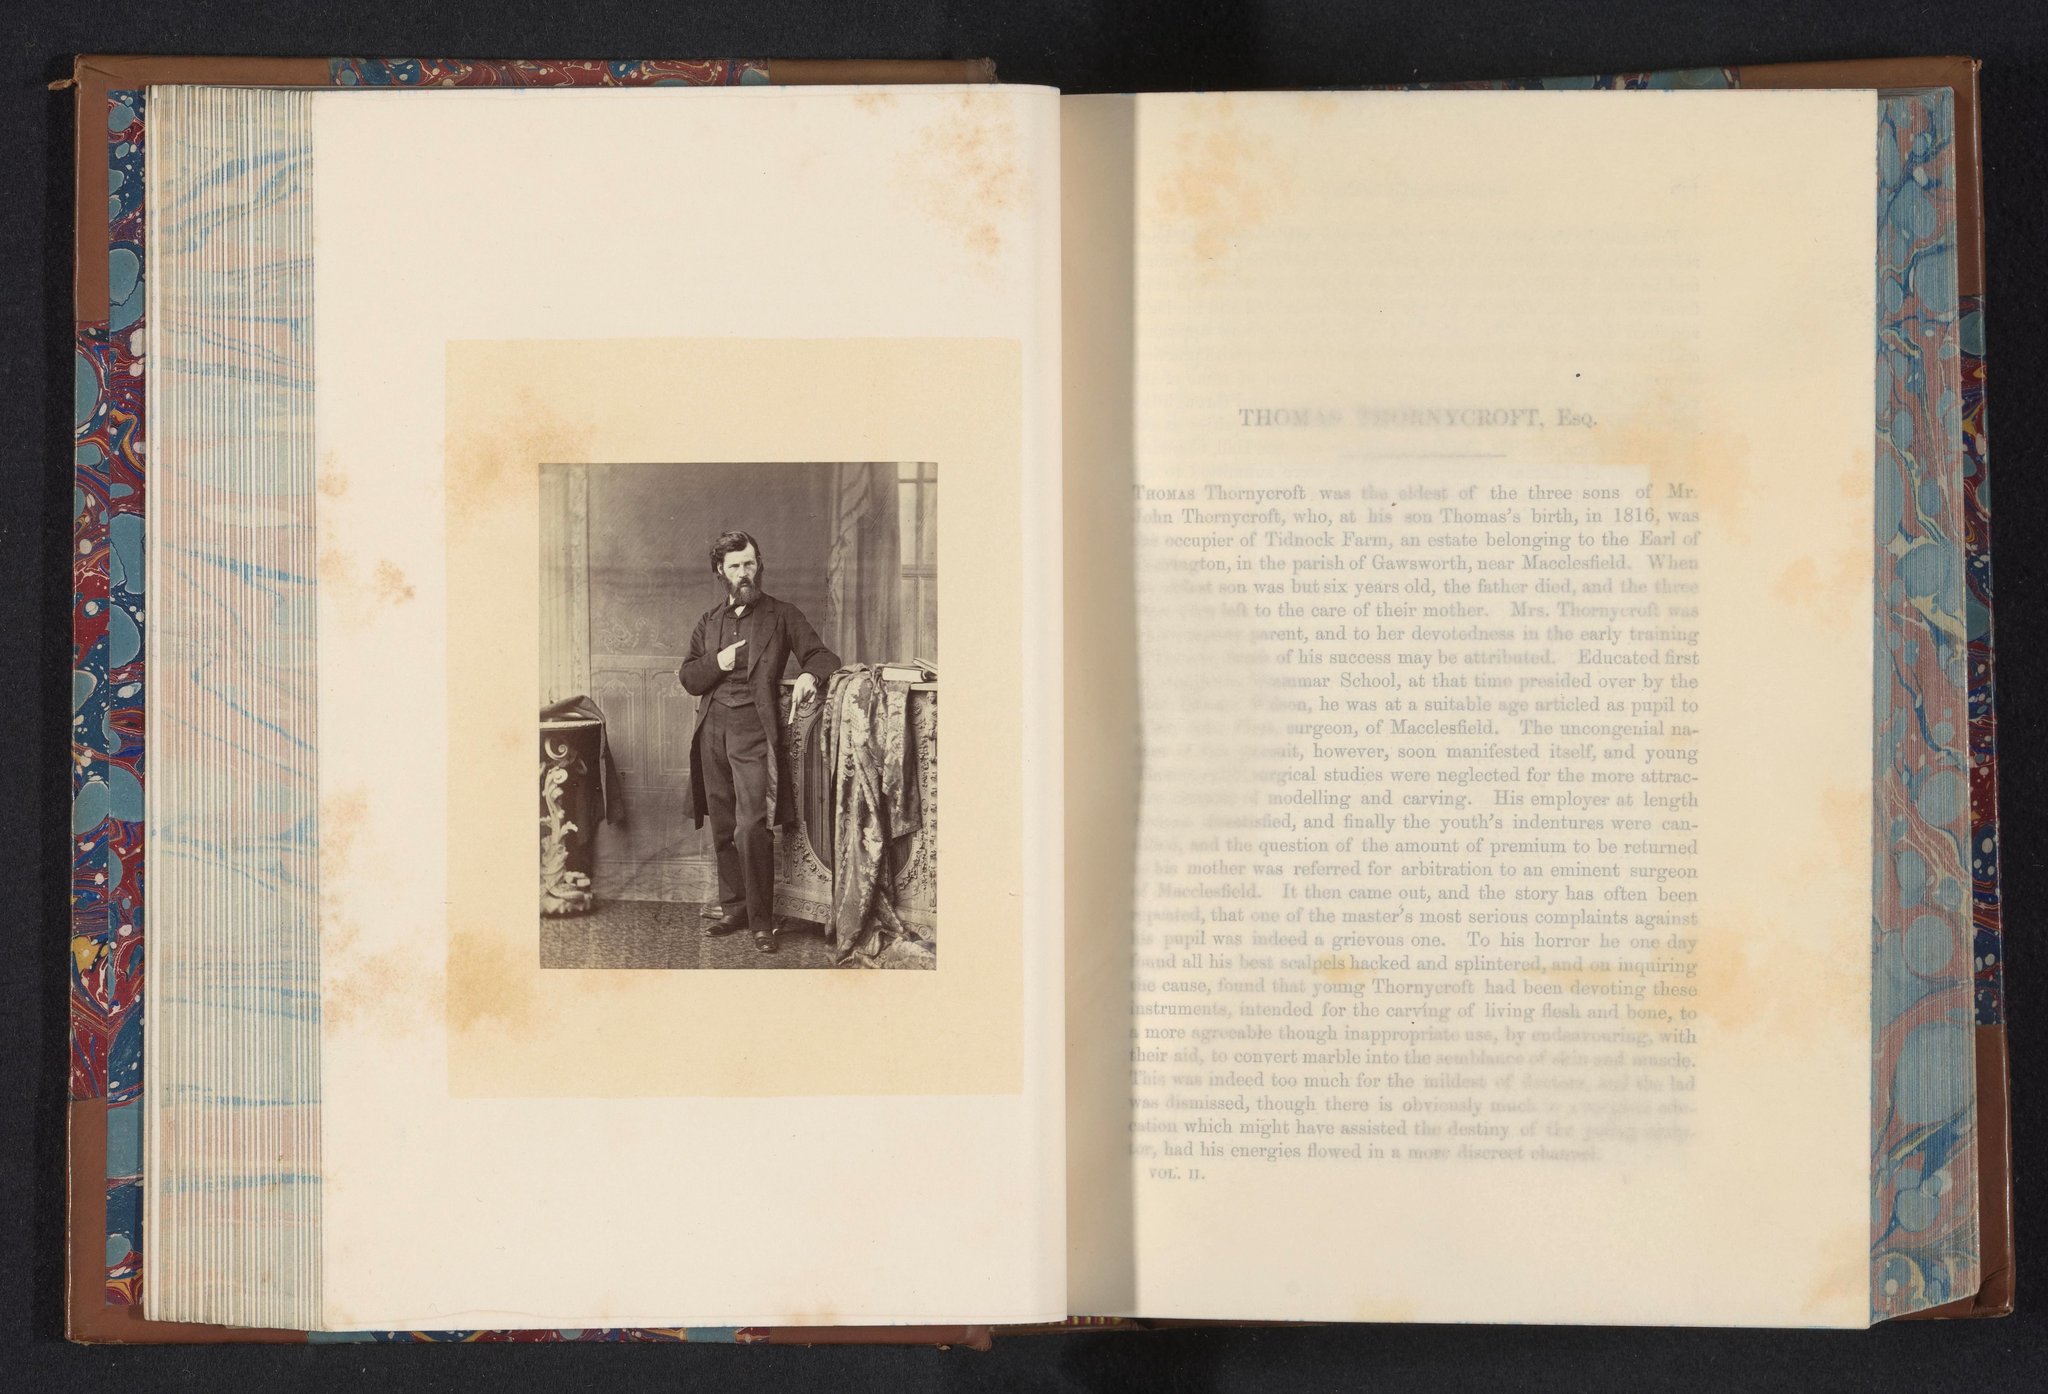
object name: page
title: Portret van Thomas Thornycroft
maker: ernest edwards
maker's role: fotograaf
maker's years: 1837-1903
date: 1853-1867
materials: photographic support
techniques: albumen print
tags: portrait, self-portrait of sculptor